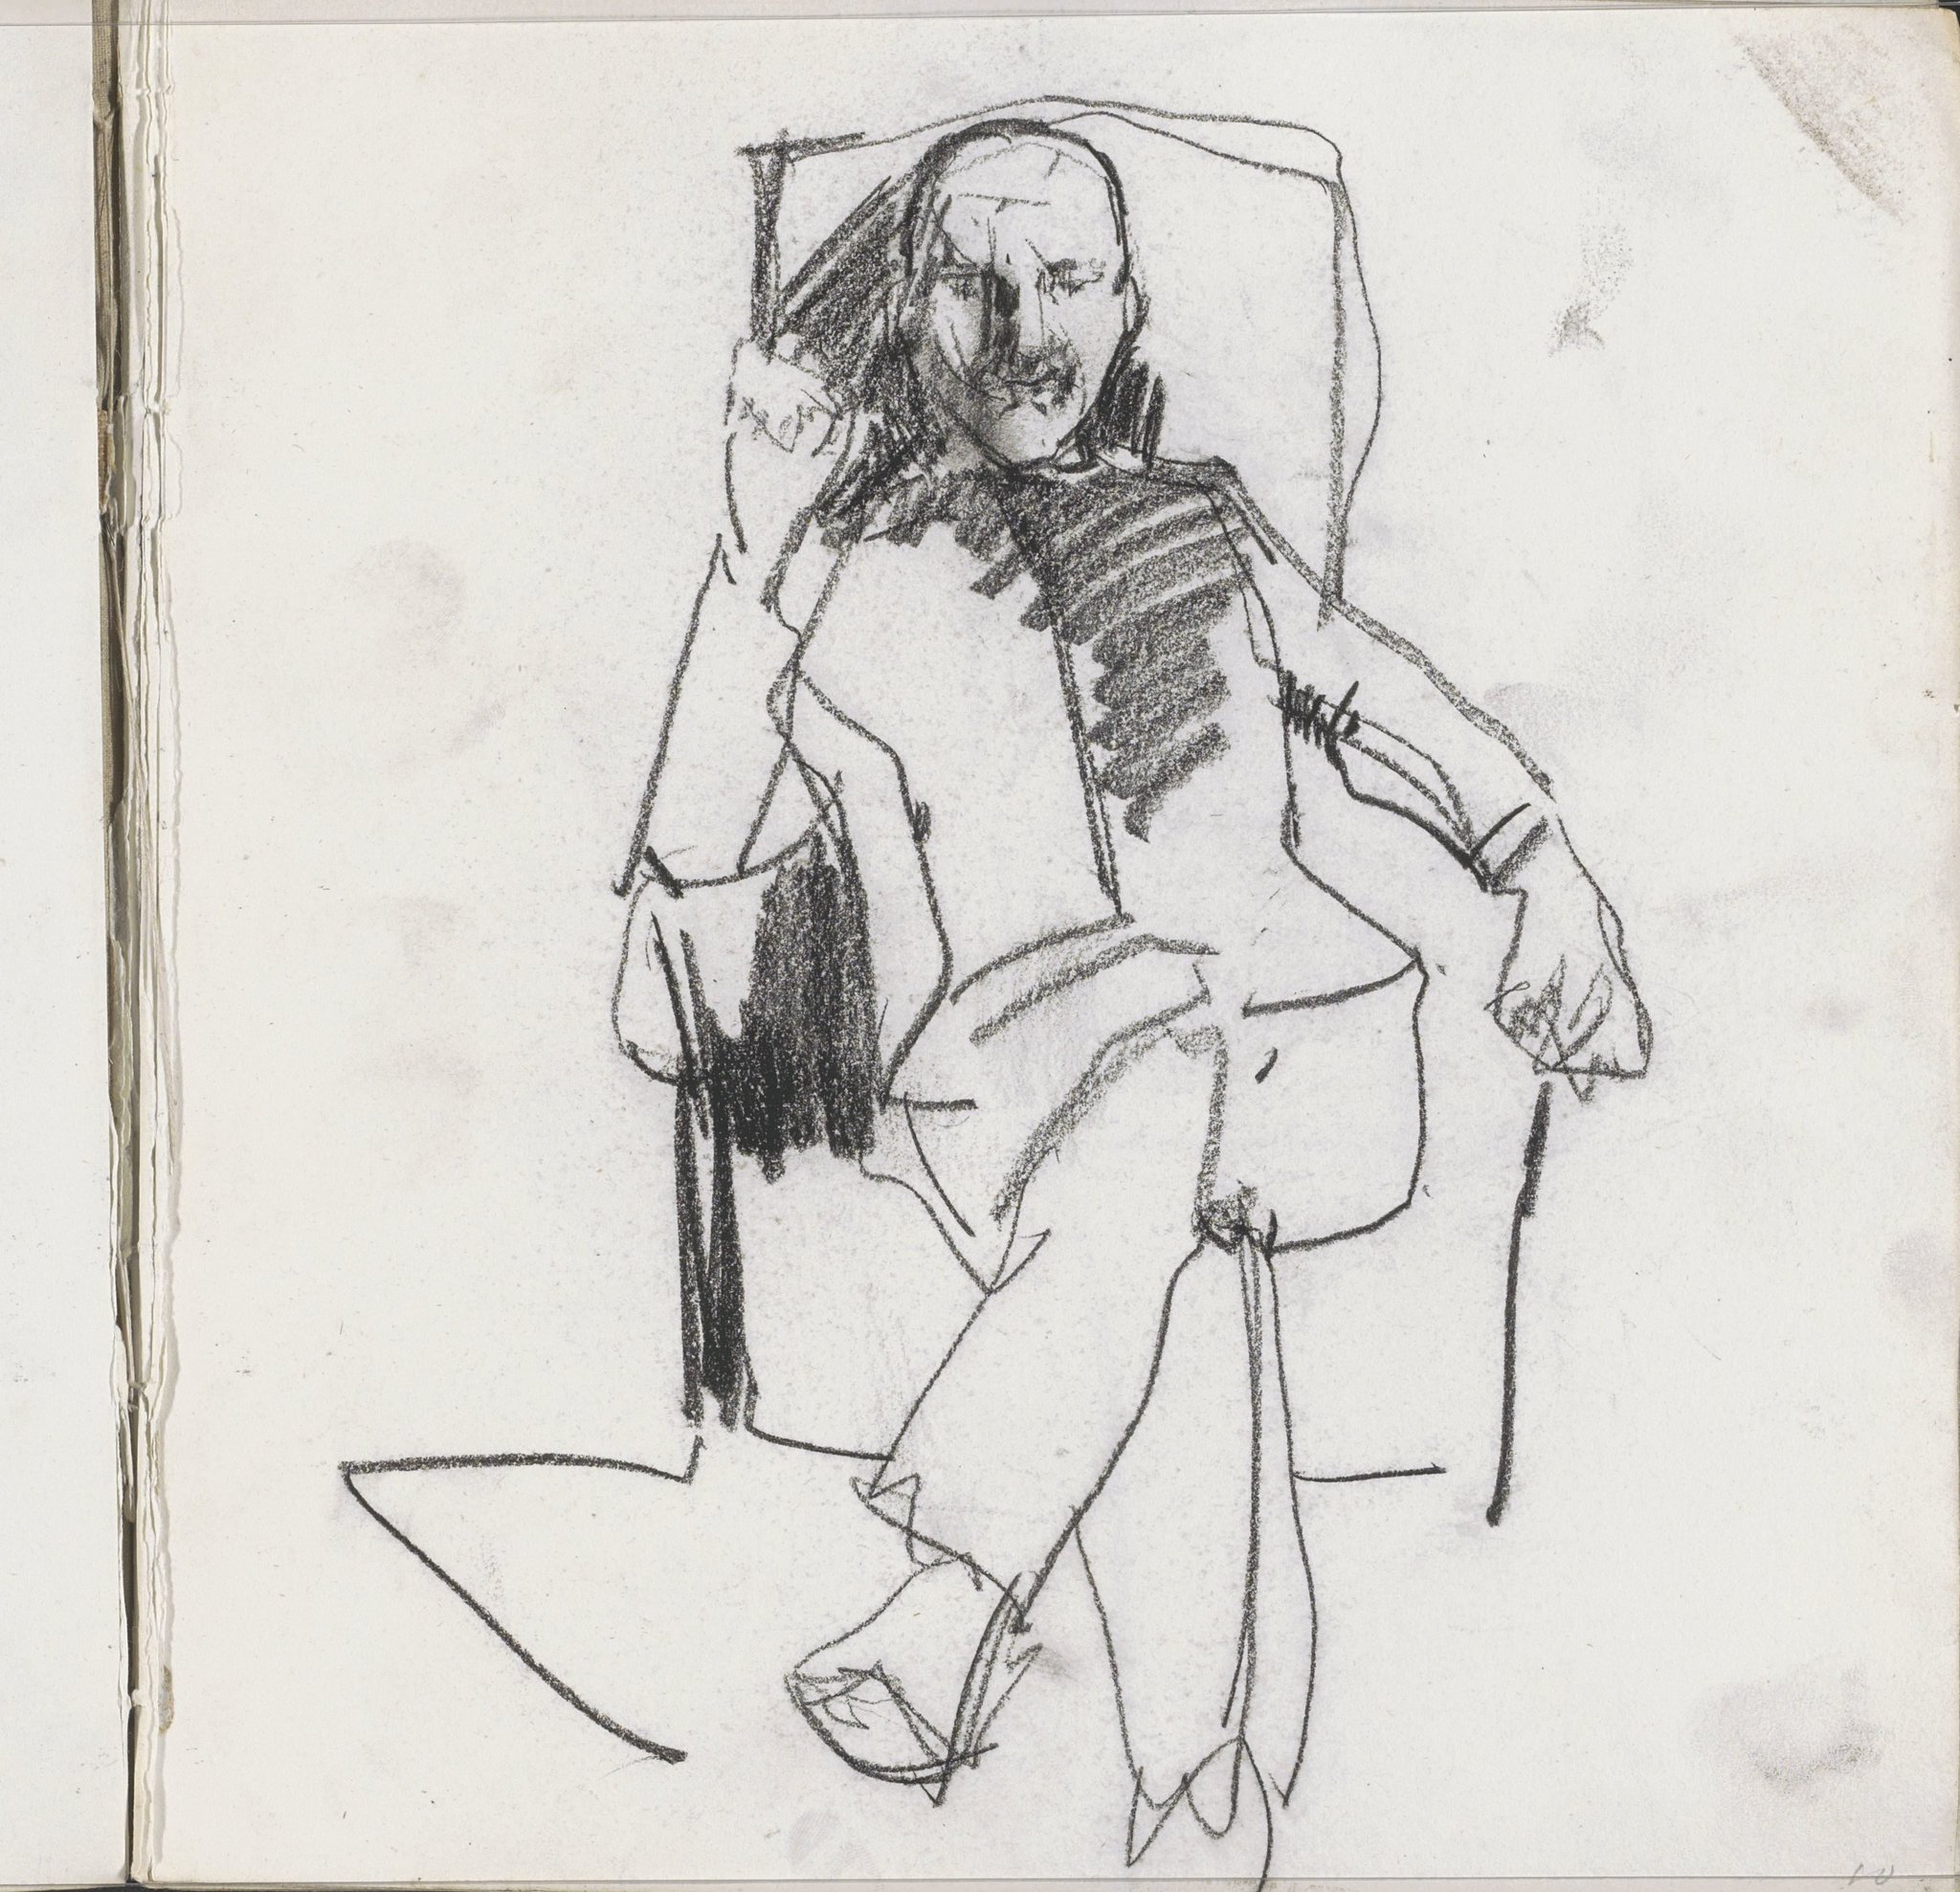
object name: sketchbook leaf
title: Man in een fauteuil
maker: isaac israels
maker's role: draughtsman, painter, print maker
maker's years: 1865-1934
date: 1875-1934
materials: chalk, paper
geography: the hague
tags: adult man (+ sitting), armchair, seat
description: Blad 10 recto uit schetsboek IX met 28 bladen.